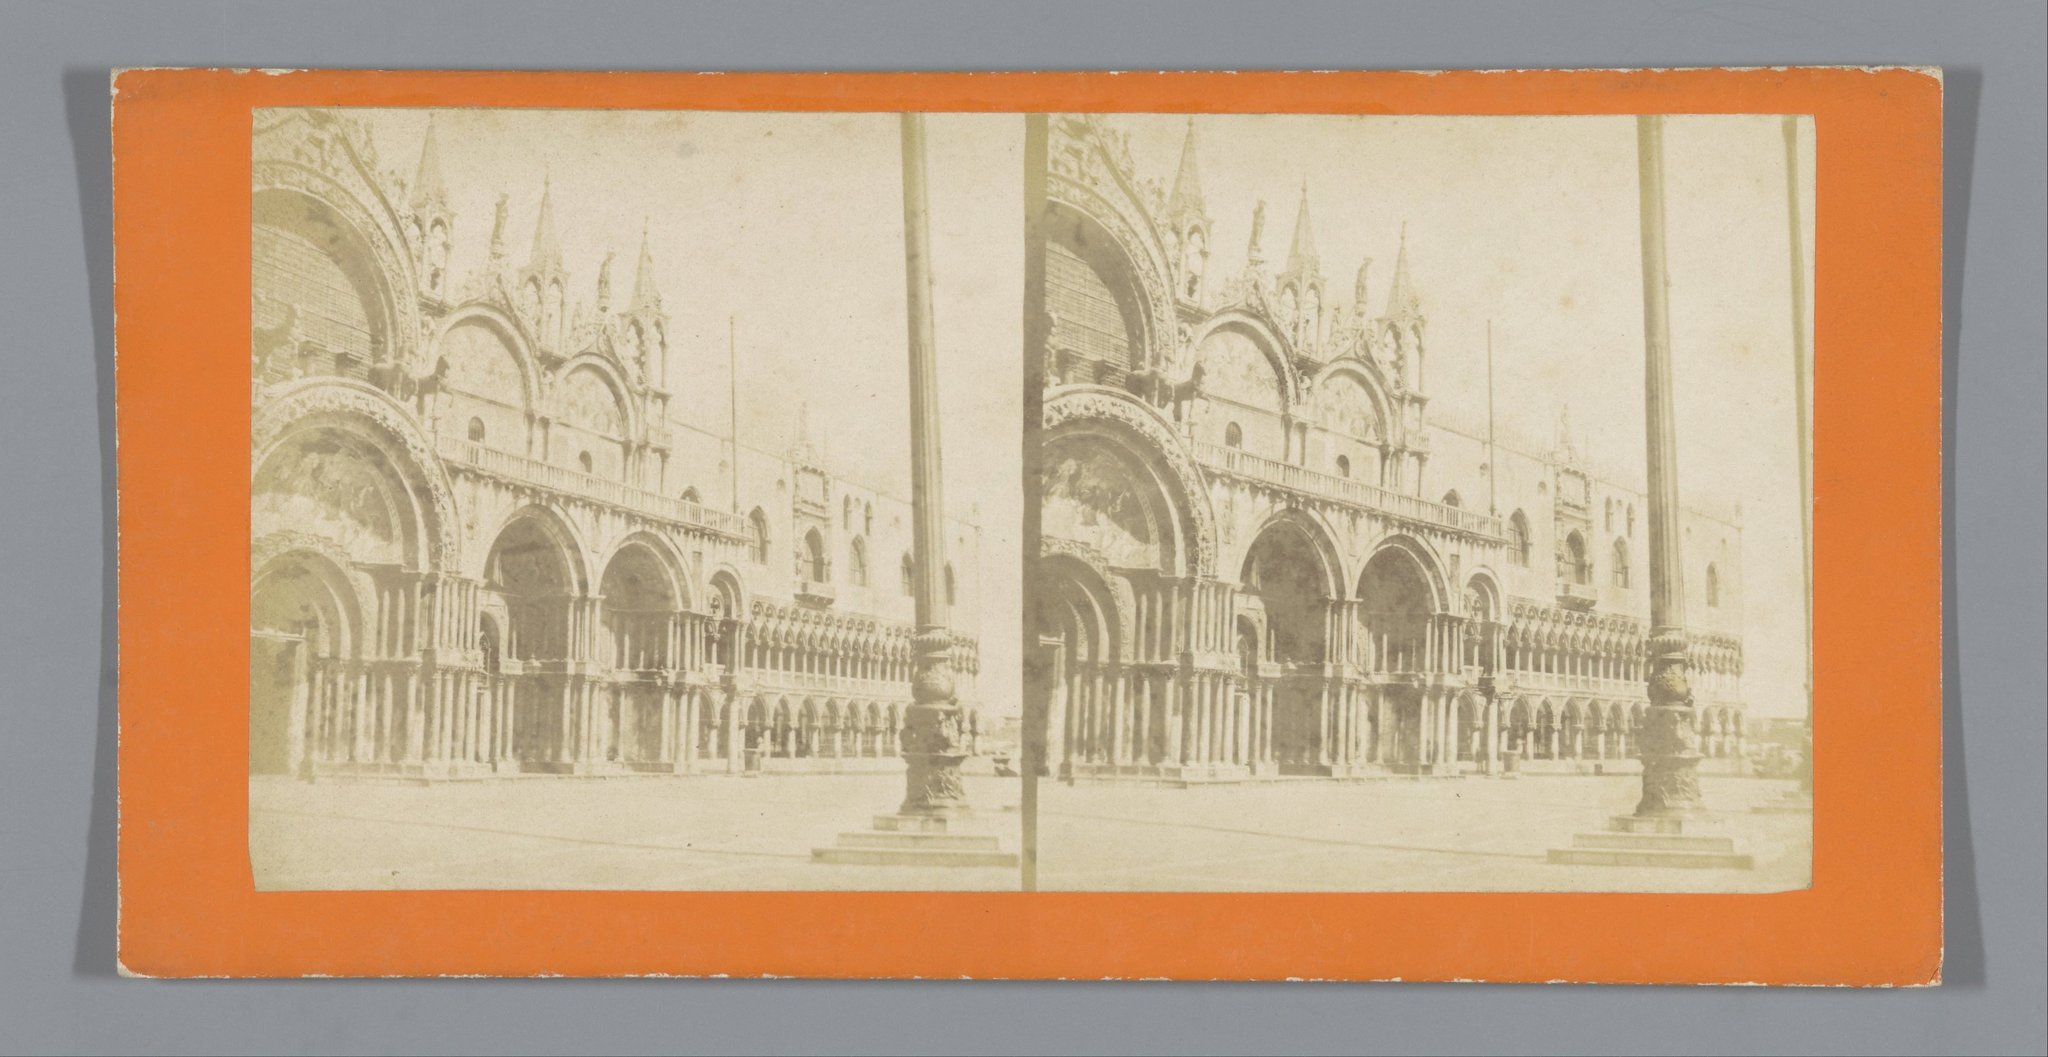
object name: stereograph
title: Voorgevel van de Basiliek van San Marco te Venetië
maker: Anonymous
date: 1850-1880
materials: cardboard, photographic support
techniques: albumen print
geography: san marco square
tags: church (exterior), façade (of house or building)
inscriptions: number: ‘62’, inscription: ‘Perspective de St Marc et du palais ducal Venise’